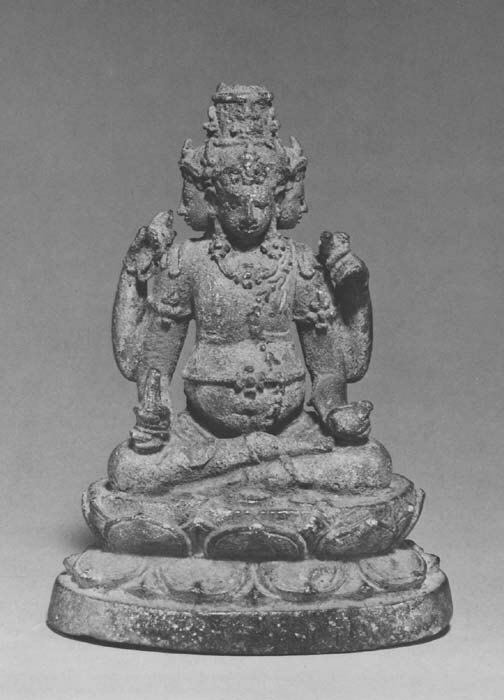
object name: figurine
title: Seated Four-Headed and Four-Armed Jambhala(?), the Buddhist God of Wealth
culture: indonesian, javanese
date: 867-933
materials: bronze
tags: buddhism,deities